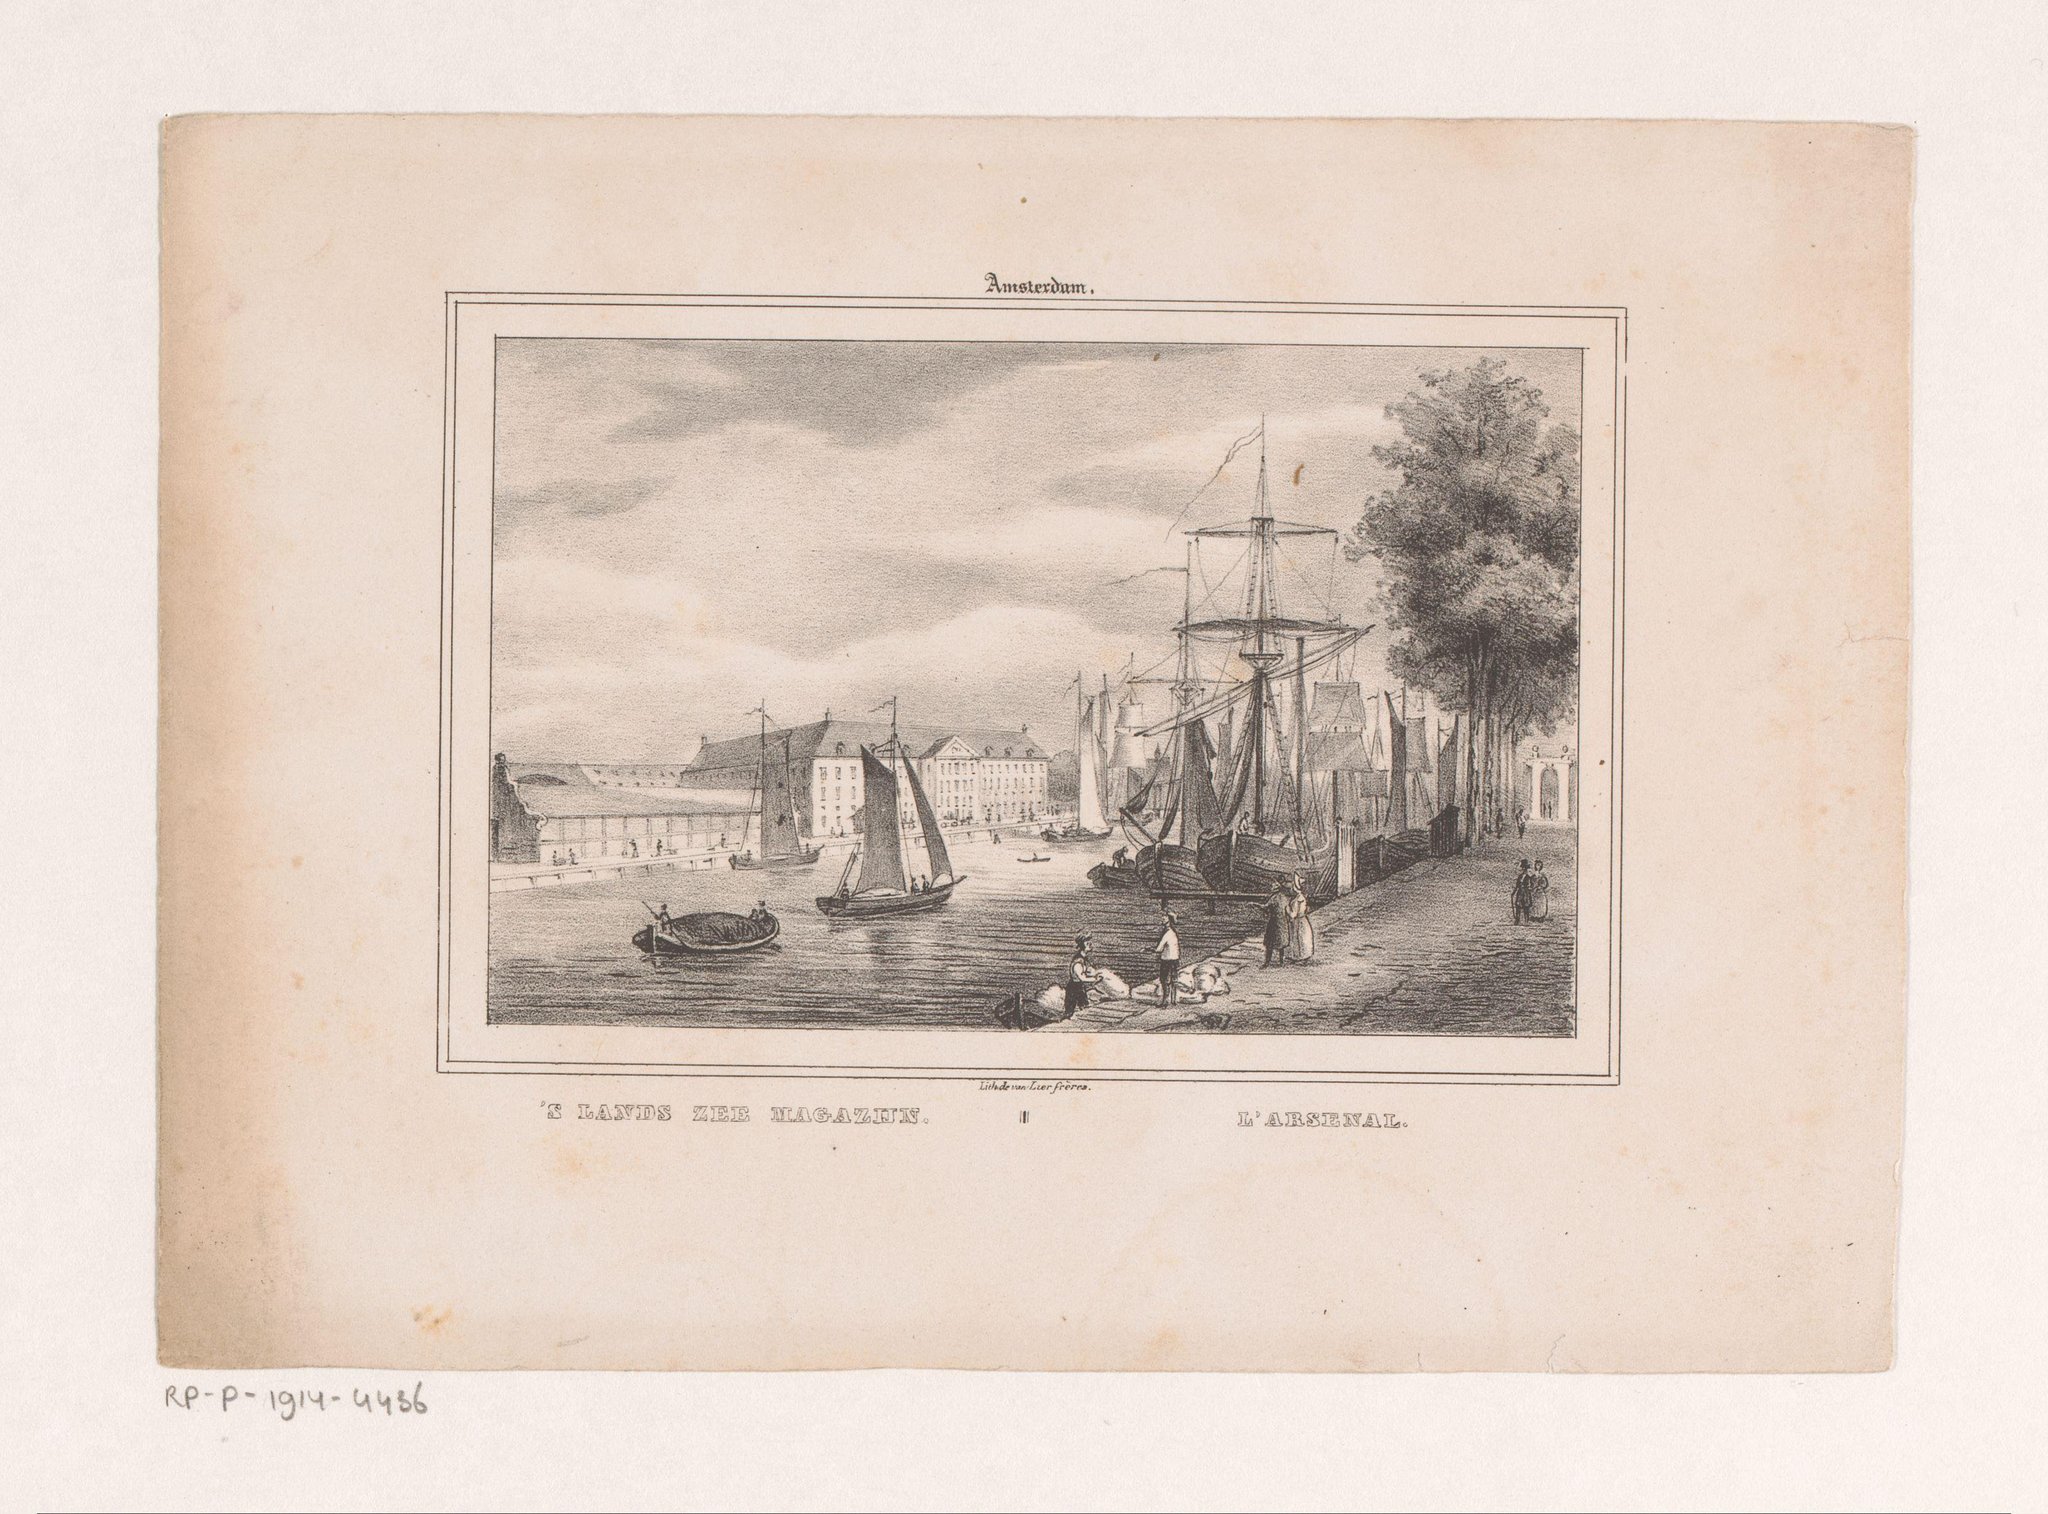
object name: print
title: 's lands zee magazijn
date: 1833-1850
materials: paper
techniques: lithograph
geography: the hague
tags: large-scale structure for storage, e.g.: warehouse, depot, silo, sailing-ship, sailing-boat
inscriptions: collector's mark: Lugt 2228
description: Het gebouw is gezien vanaf de overkant van het water, vanaf het Oosterdok. Op het water liggen zeilschepen.